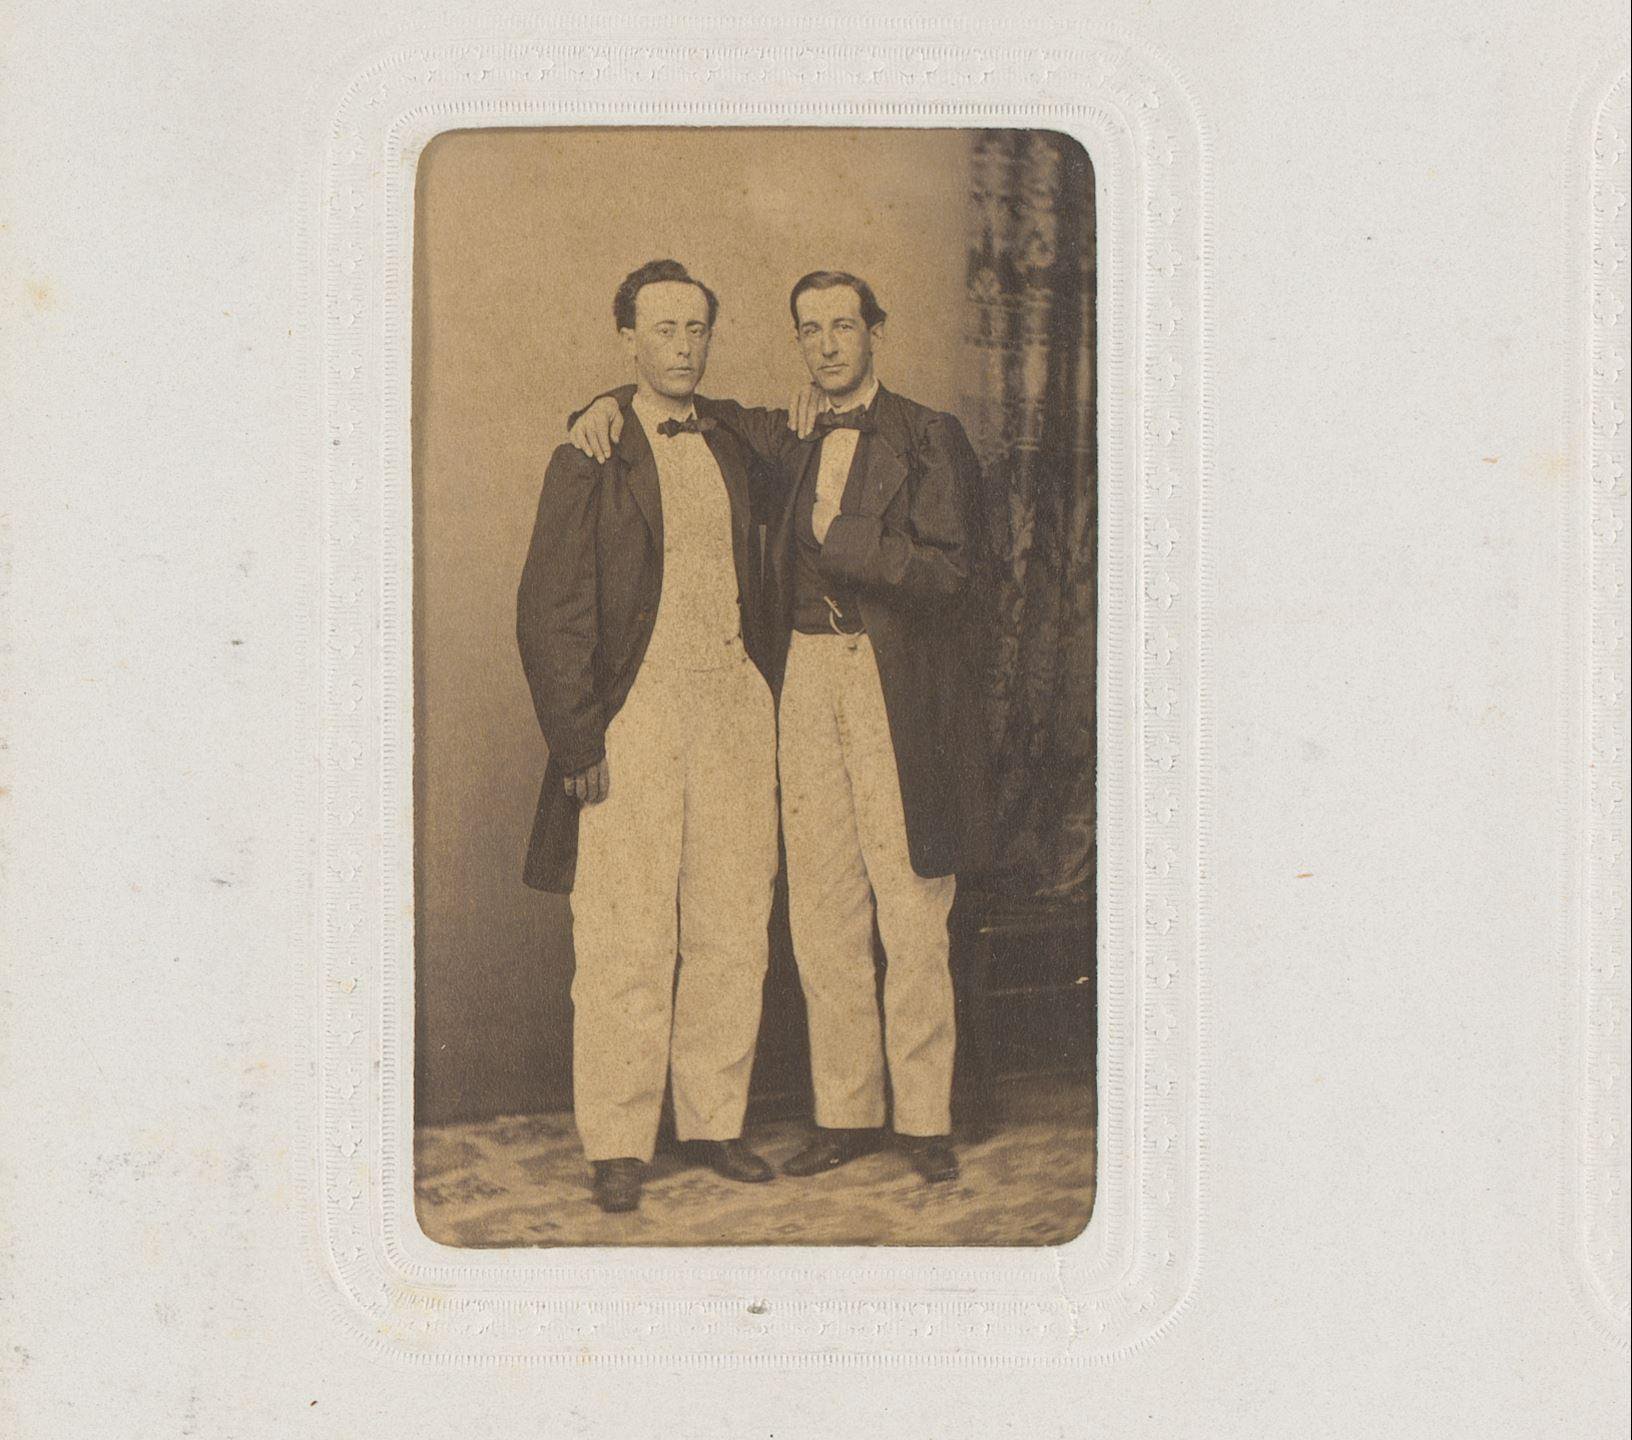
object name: album leaf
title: Portret van twee mannen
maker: Anonymous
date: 1860-1890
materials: cardboard, photographic support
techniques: albumen print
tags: historical persons, standing figure - aa - female human figure